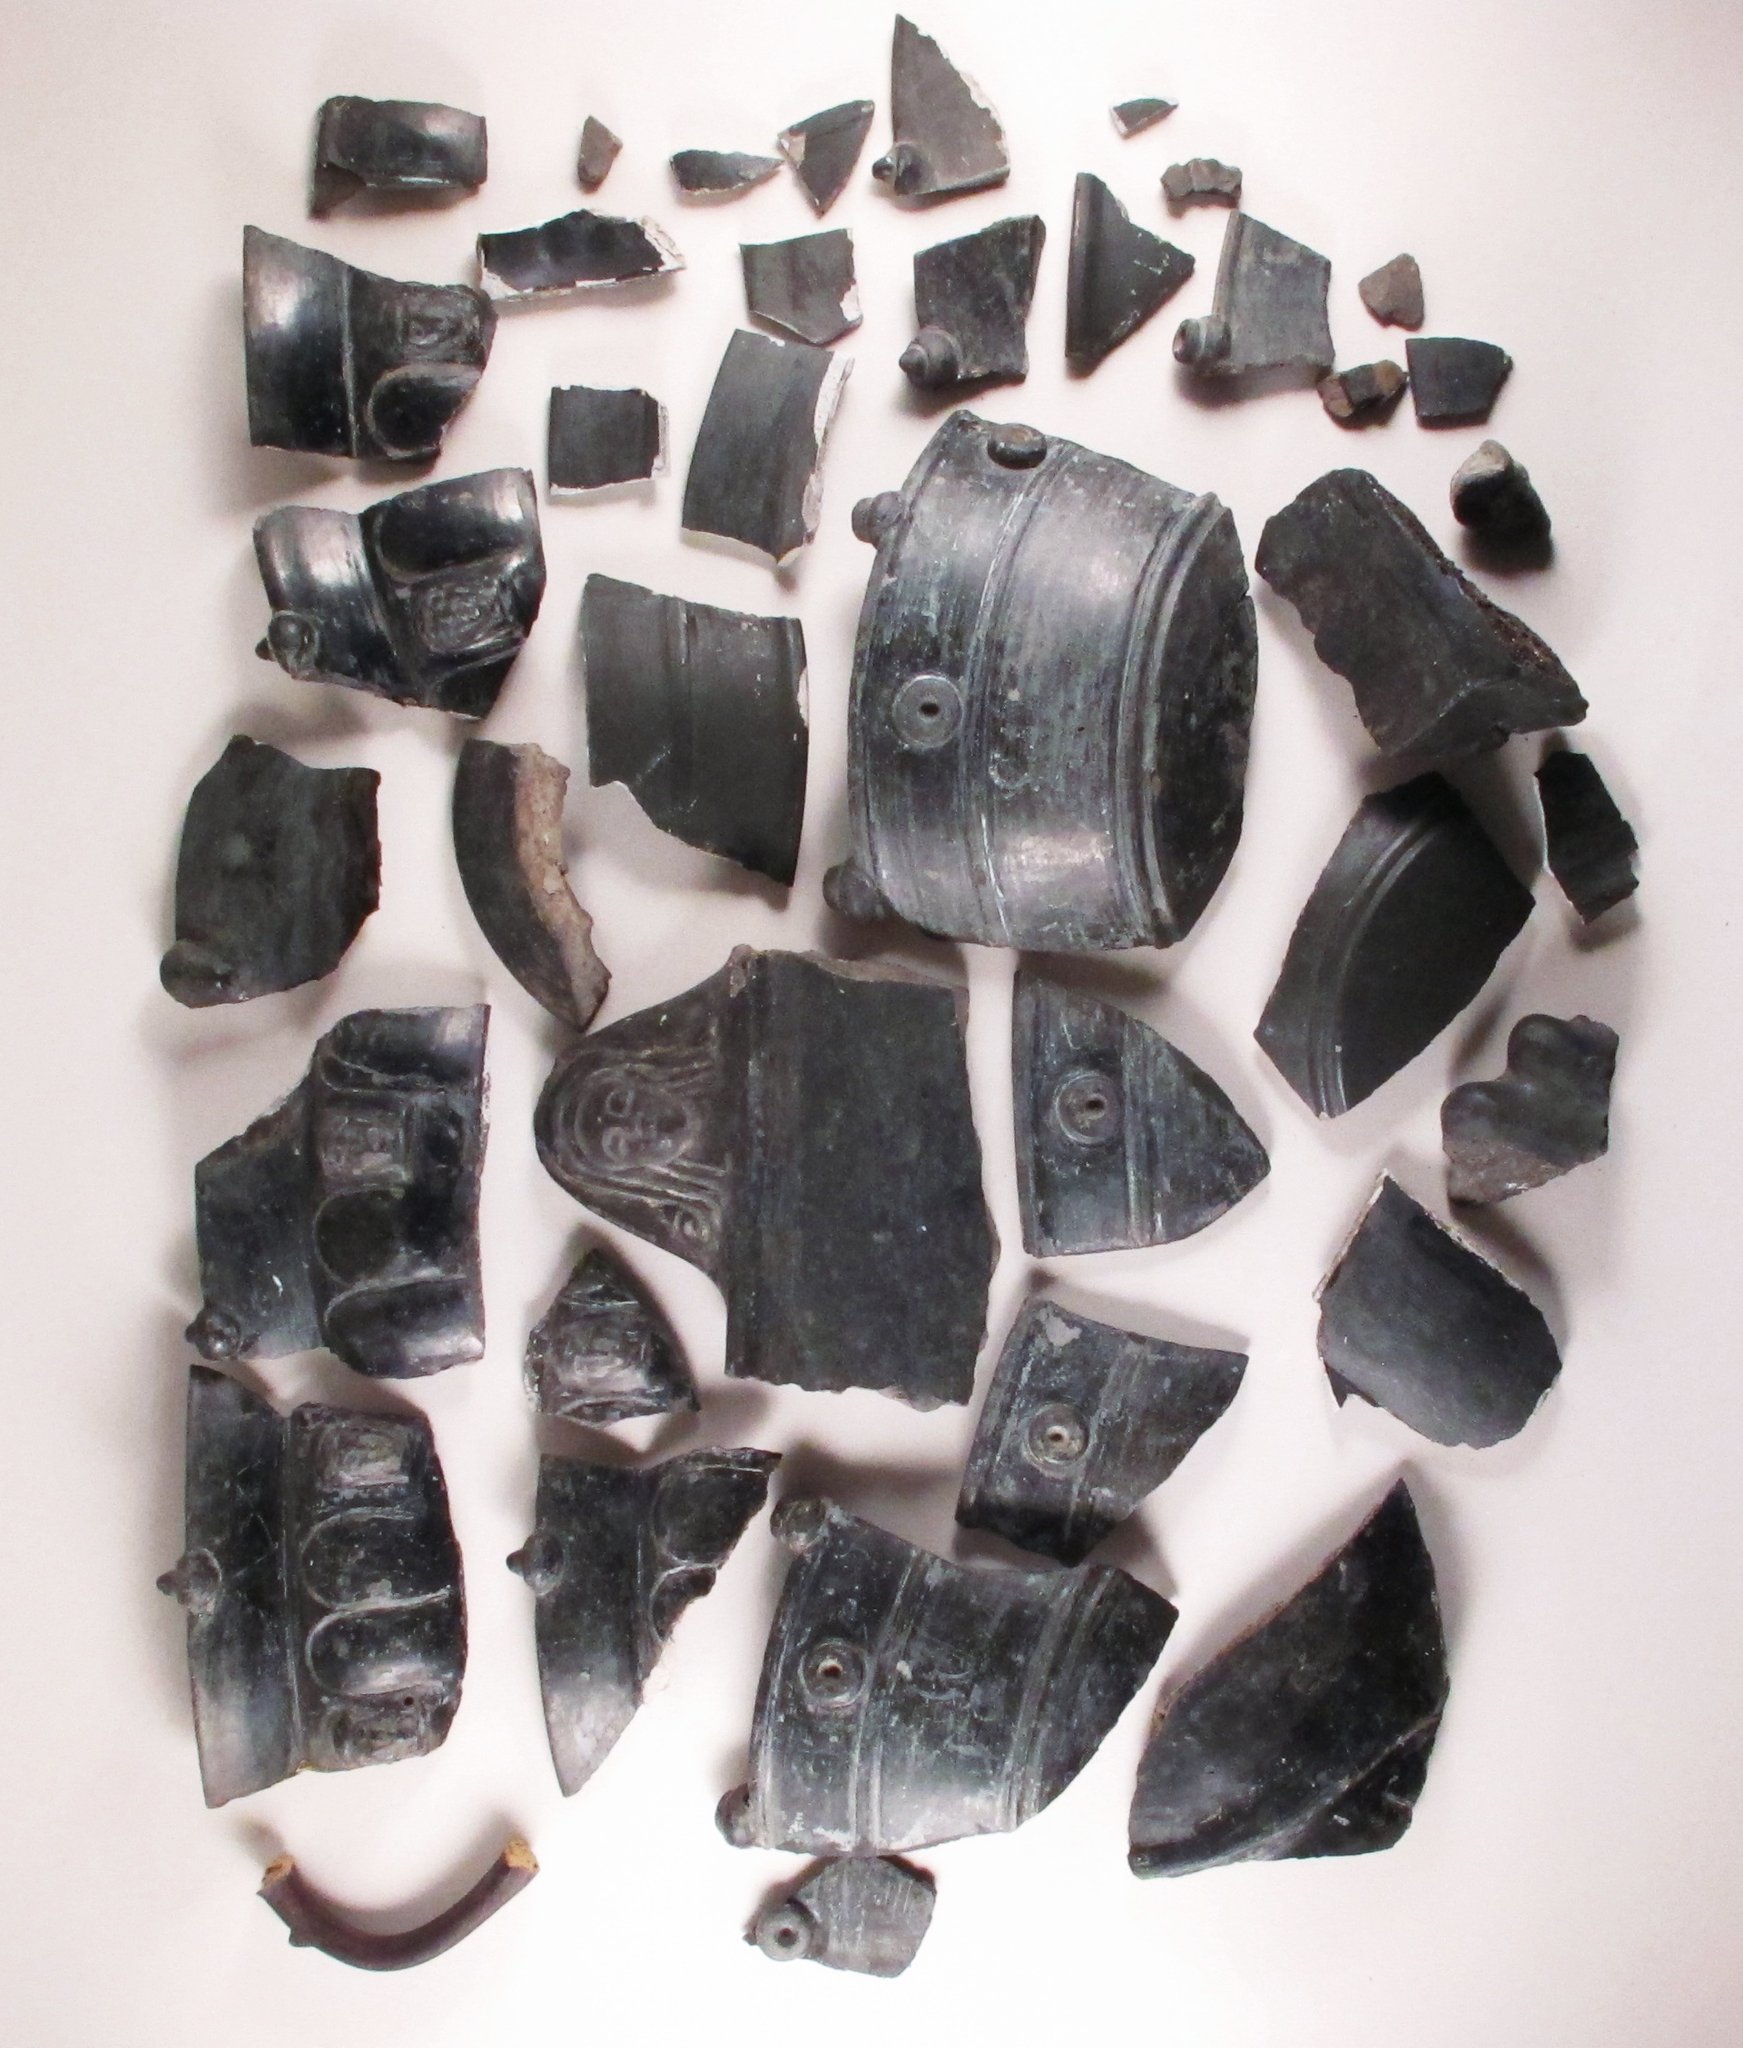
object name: cup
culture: etruscan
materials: terracotta